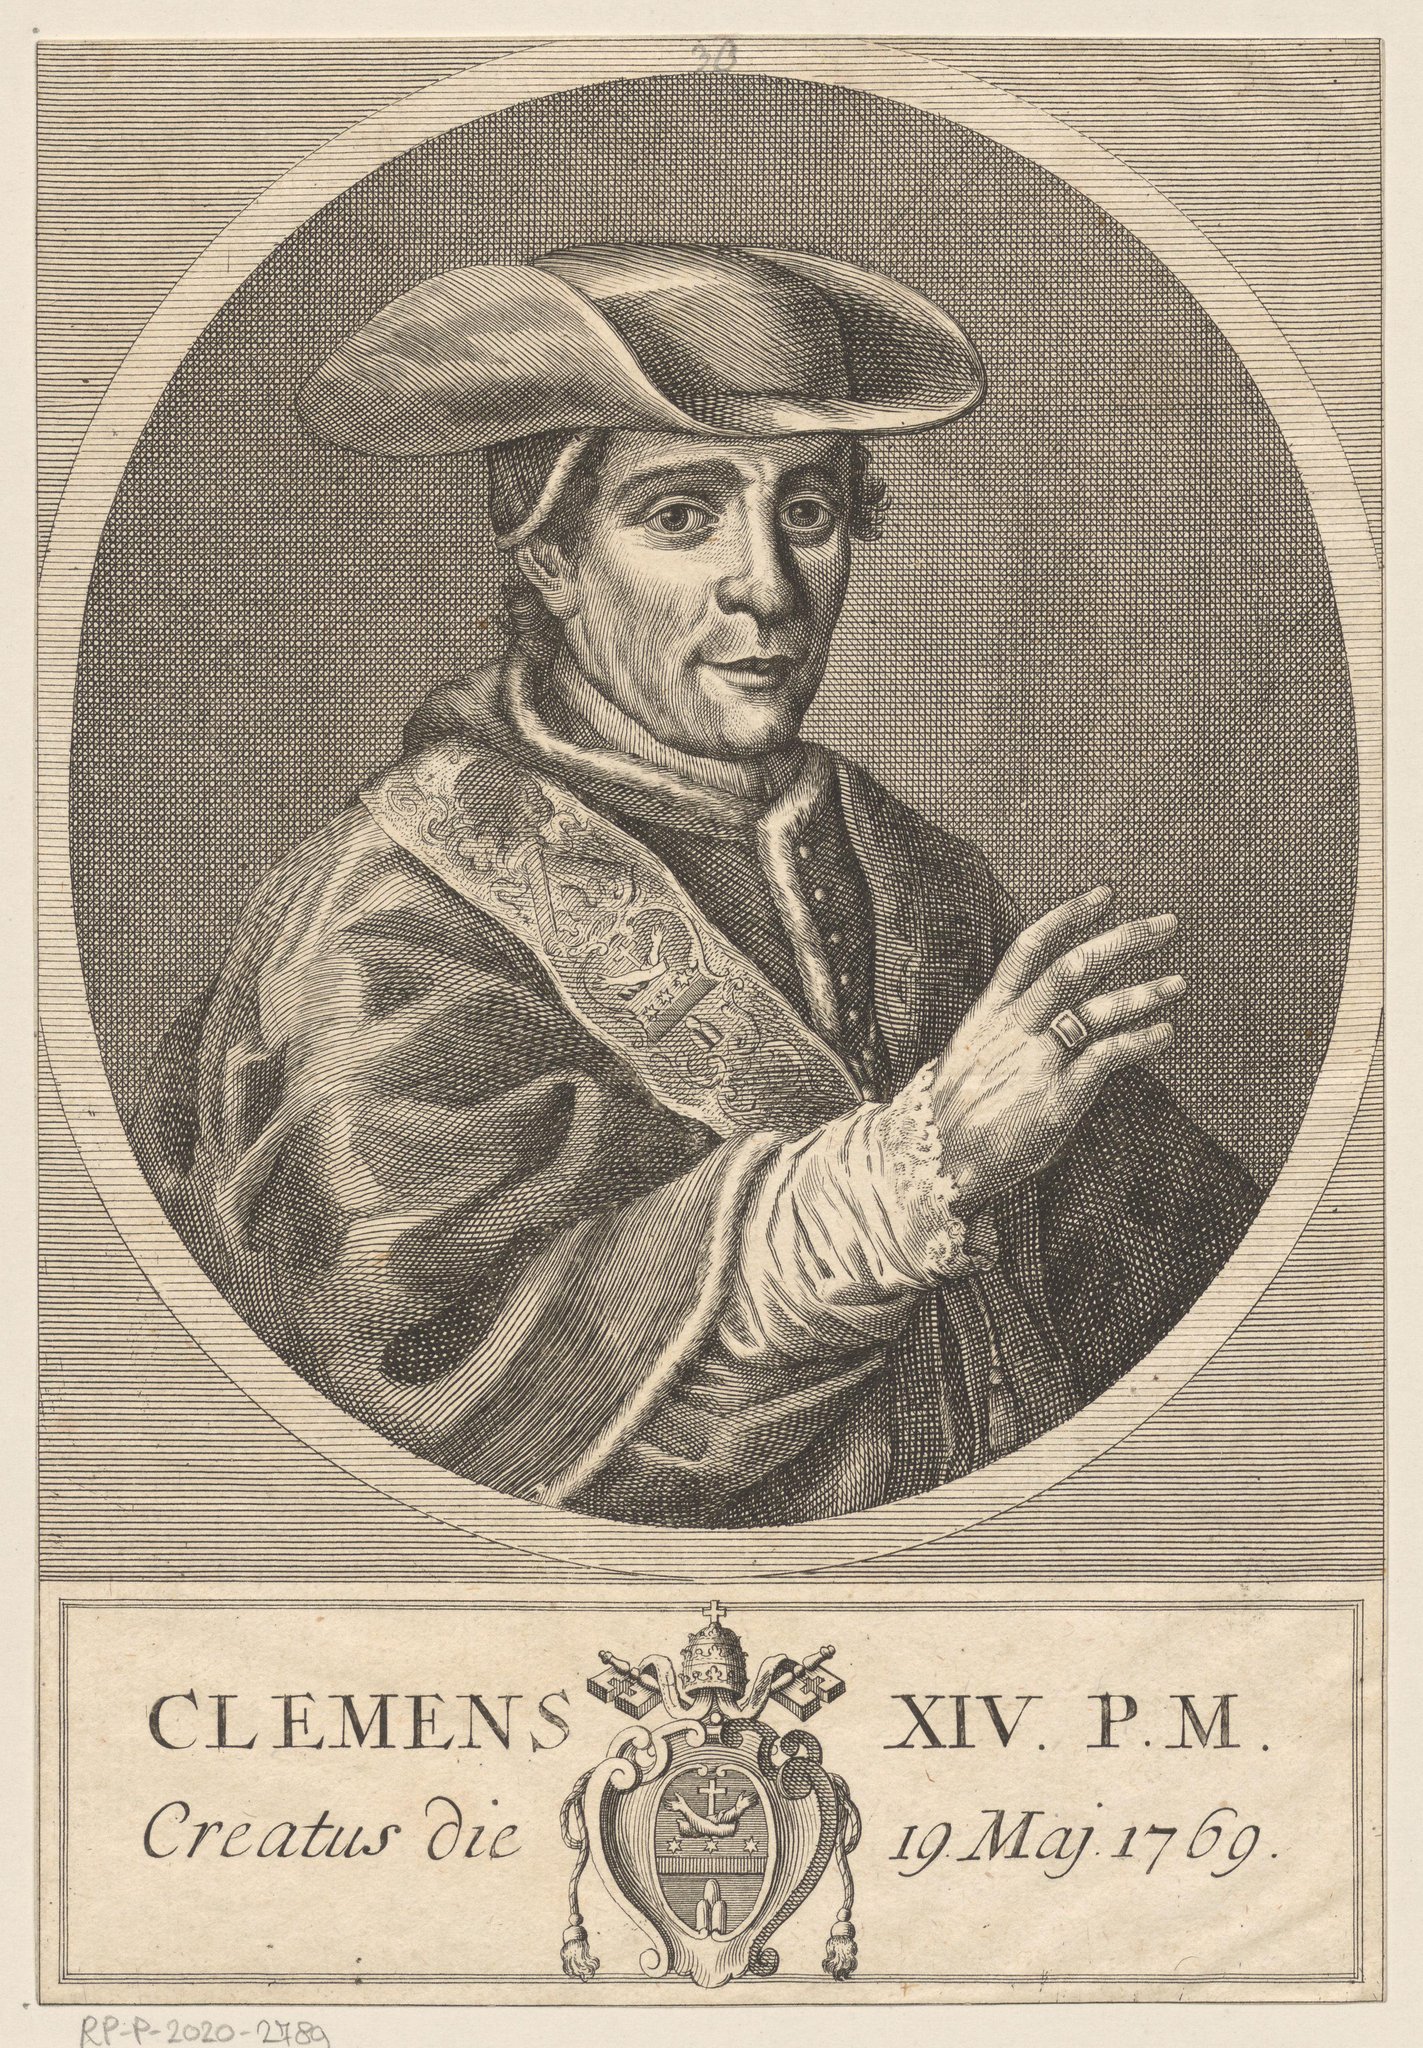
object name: print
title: Portret van paus Clemens XIV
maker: Anonymous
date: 1769-1799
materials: paper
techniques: engraving, etching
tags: rome, historical persons, pope, armorial bearing, heraldry